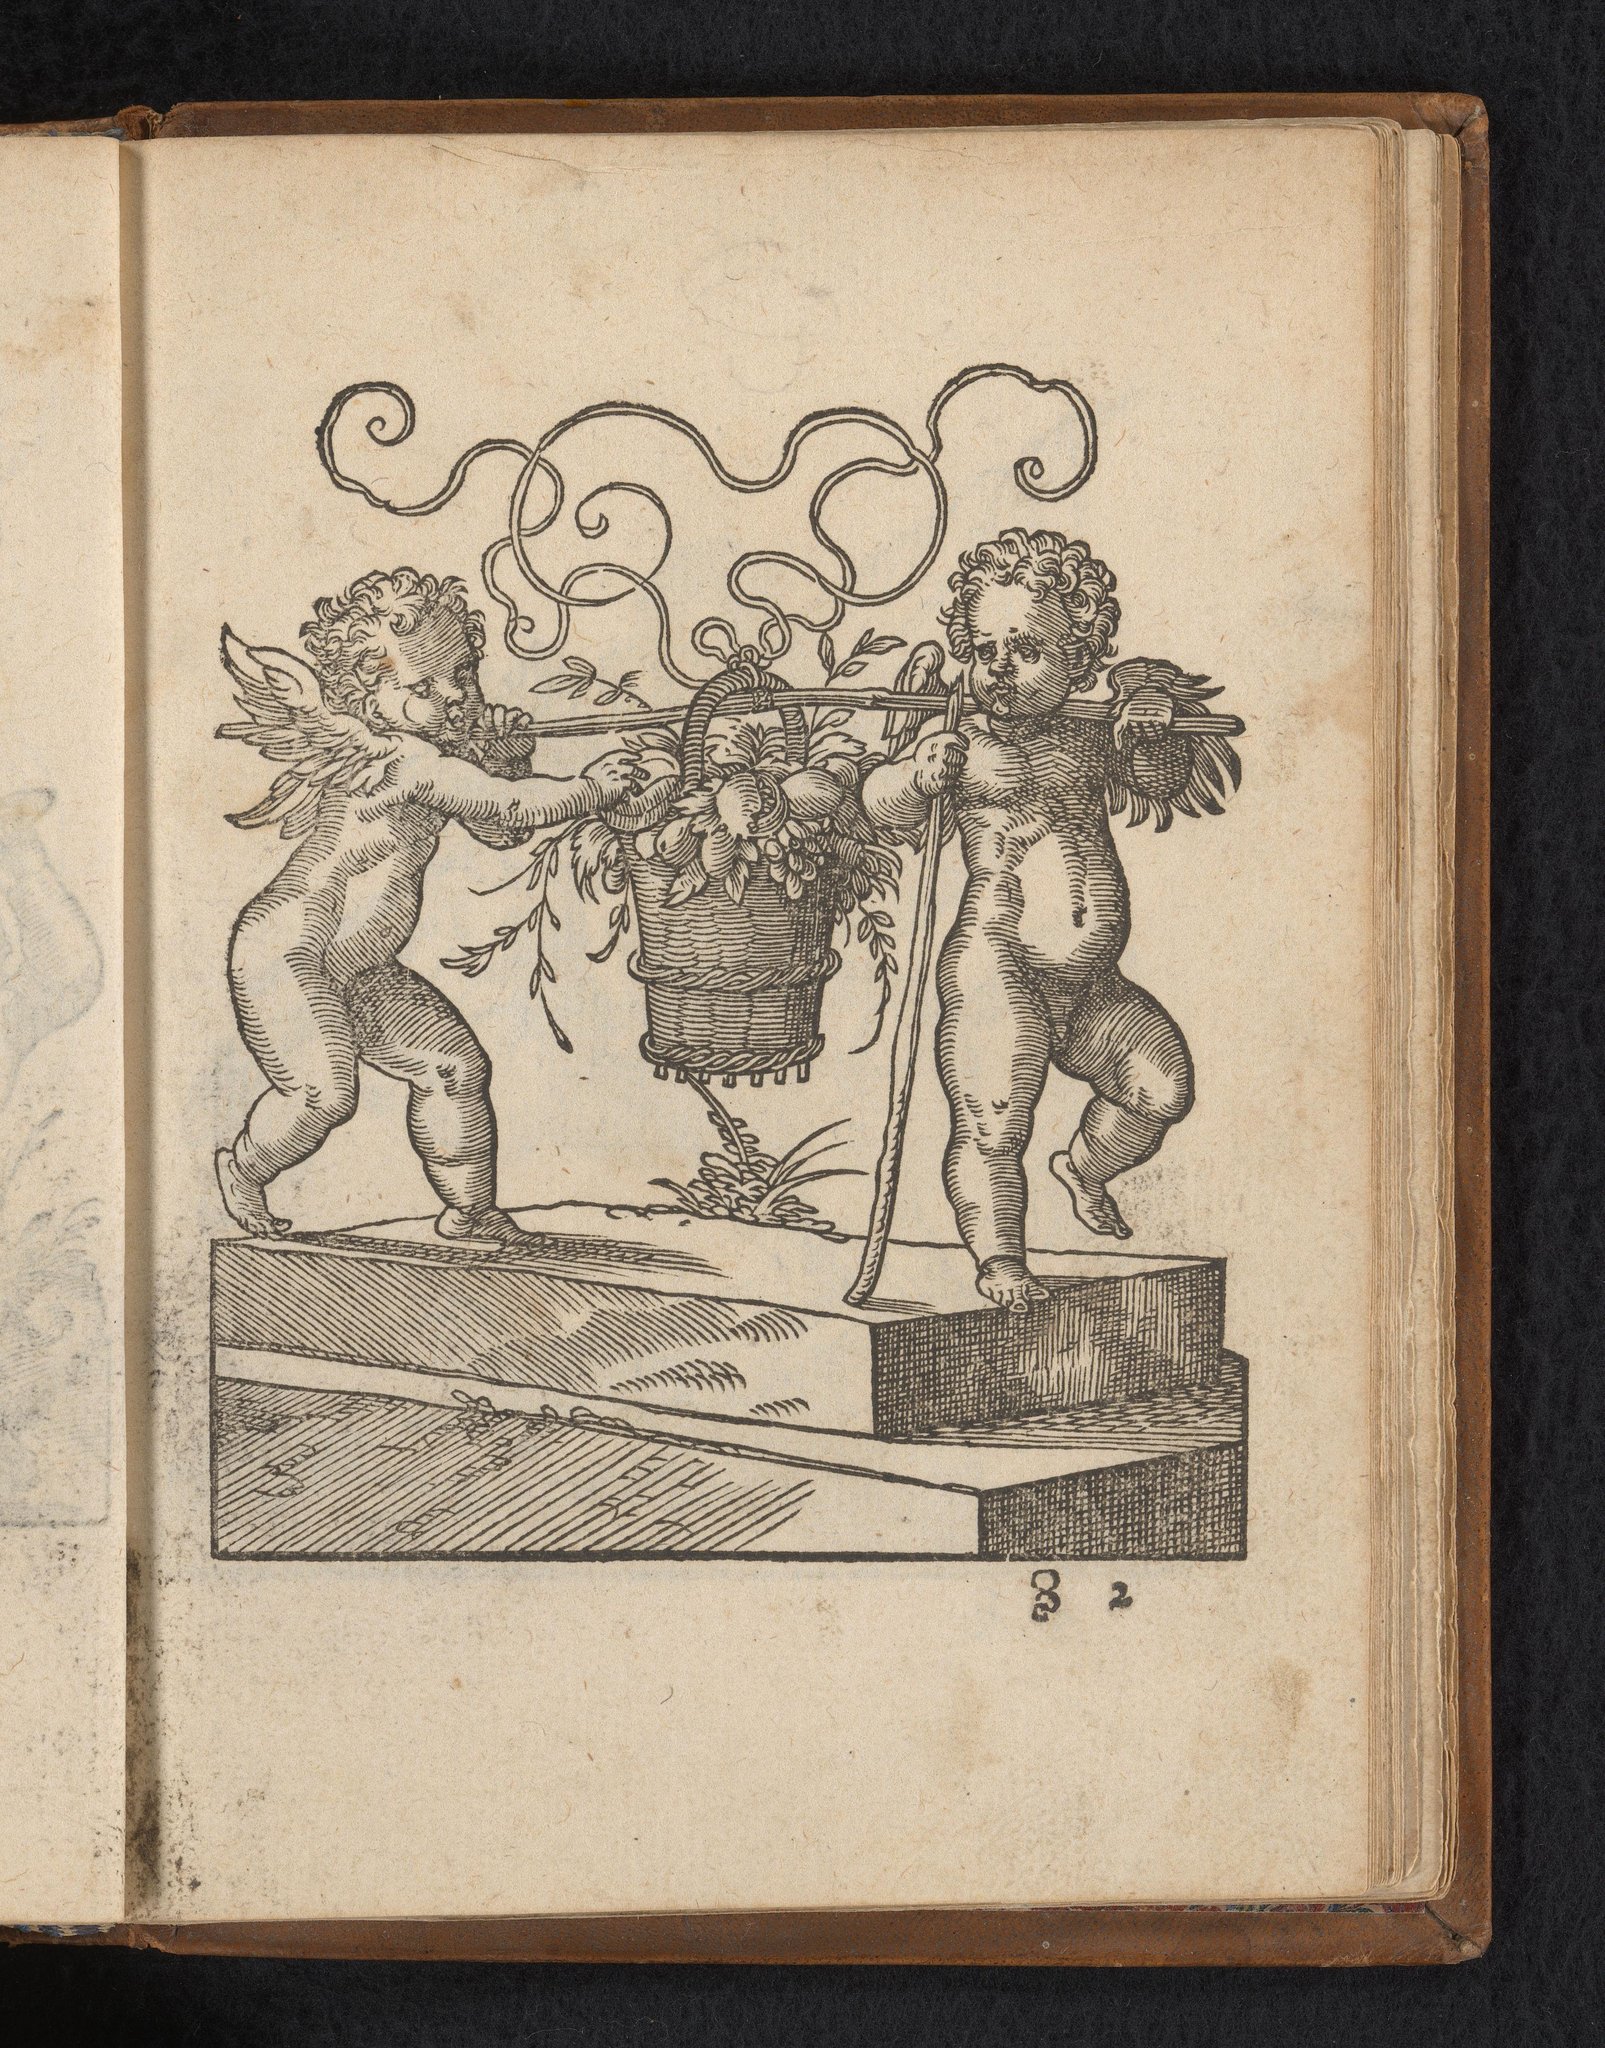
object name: print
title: Twee putti met een bloemenmand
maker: Anonymous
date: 1578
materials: paper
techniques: woodcut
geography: nuremberg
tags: fruits and vegetables ~ ornament, carrying something in basket, bag, rucksack, etc., cupids: 'amores', 'amoretti', 'putti', flowers ~ ornament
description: Twee putti dragen een man met bloemen en vruchten aan een stok. Onderdeel van het modelboek Enchiridion artis pingendi, fingendi & sculpendi met 108 figuren bedoeld voor beginnende schilders, beeldhouwers en prentmakers.